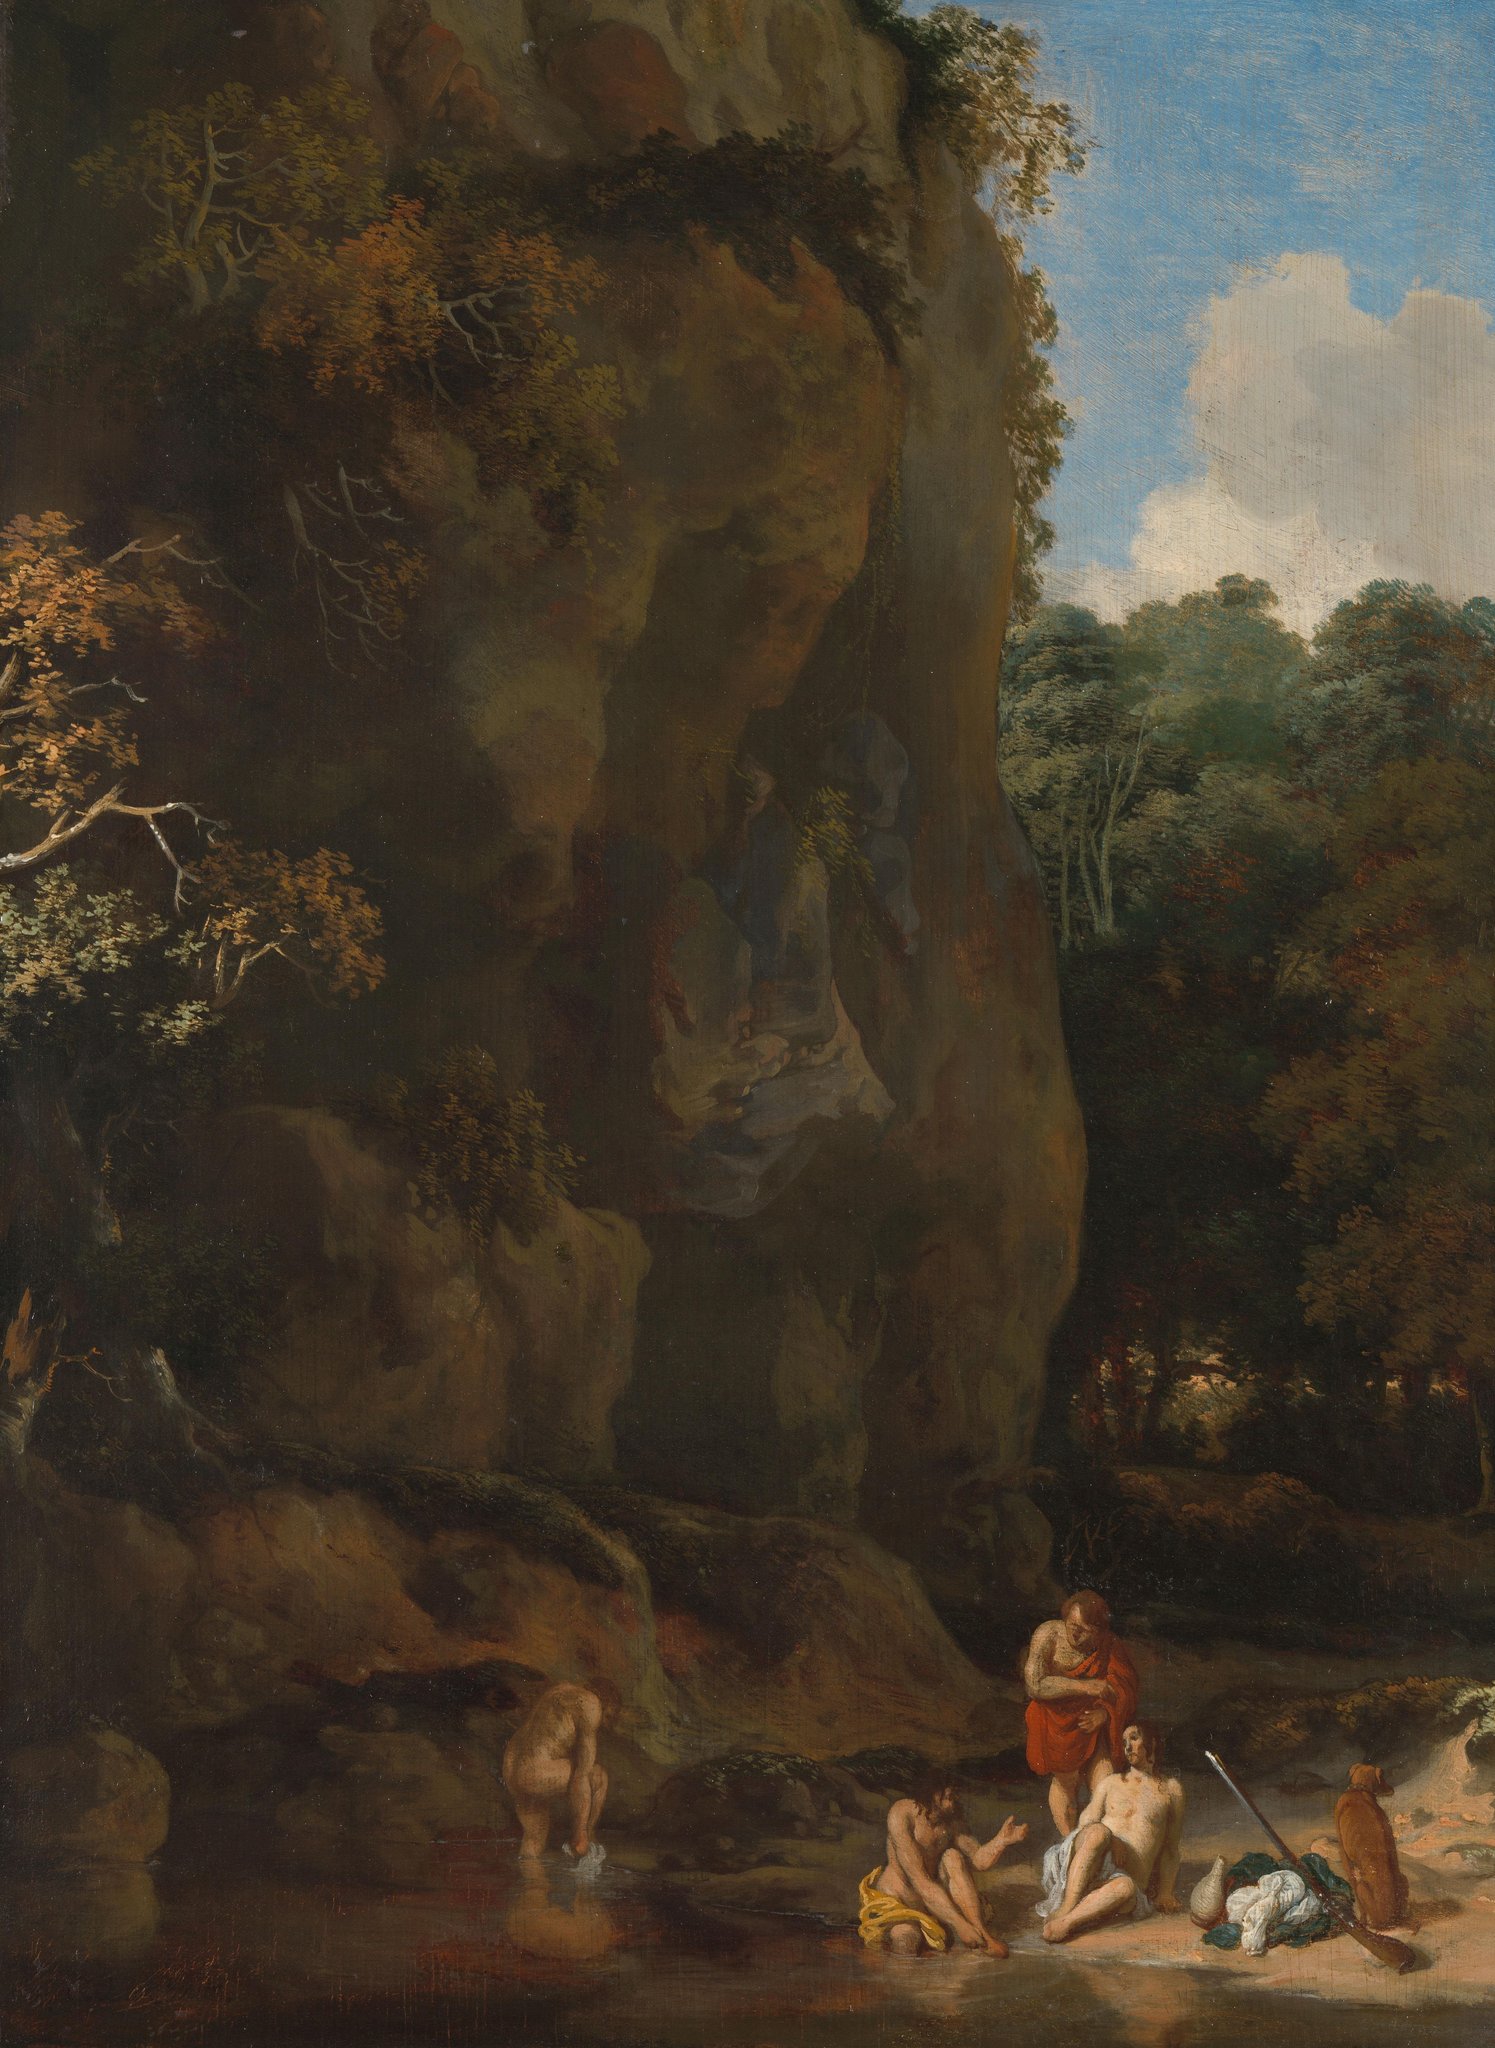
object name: painting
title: Men Bathing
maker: gerbrand van den eeckhout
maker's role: draughtsman, print maker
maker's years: 1621-1674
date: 1650-1674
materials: oil, panel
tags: taking a bath - aa - in the open air, rocks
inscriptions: signature: ‘G. Eeckhout’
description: Een groepje badende en pratende mannen aan de voet van een rotswand. Rechts de bomen van een bos.